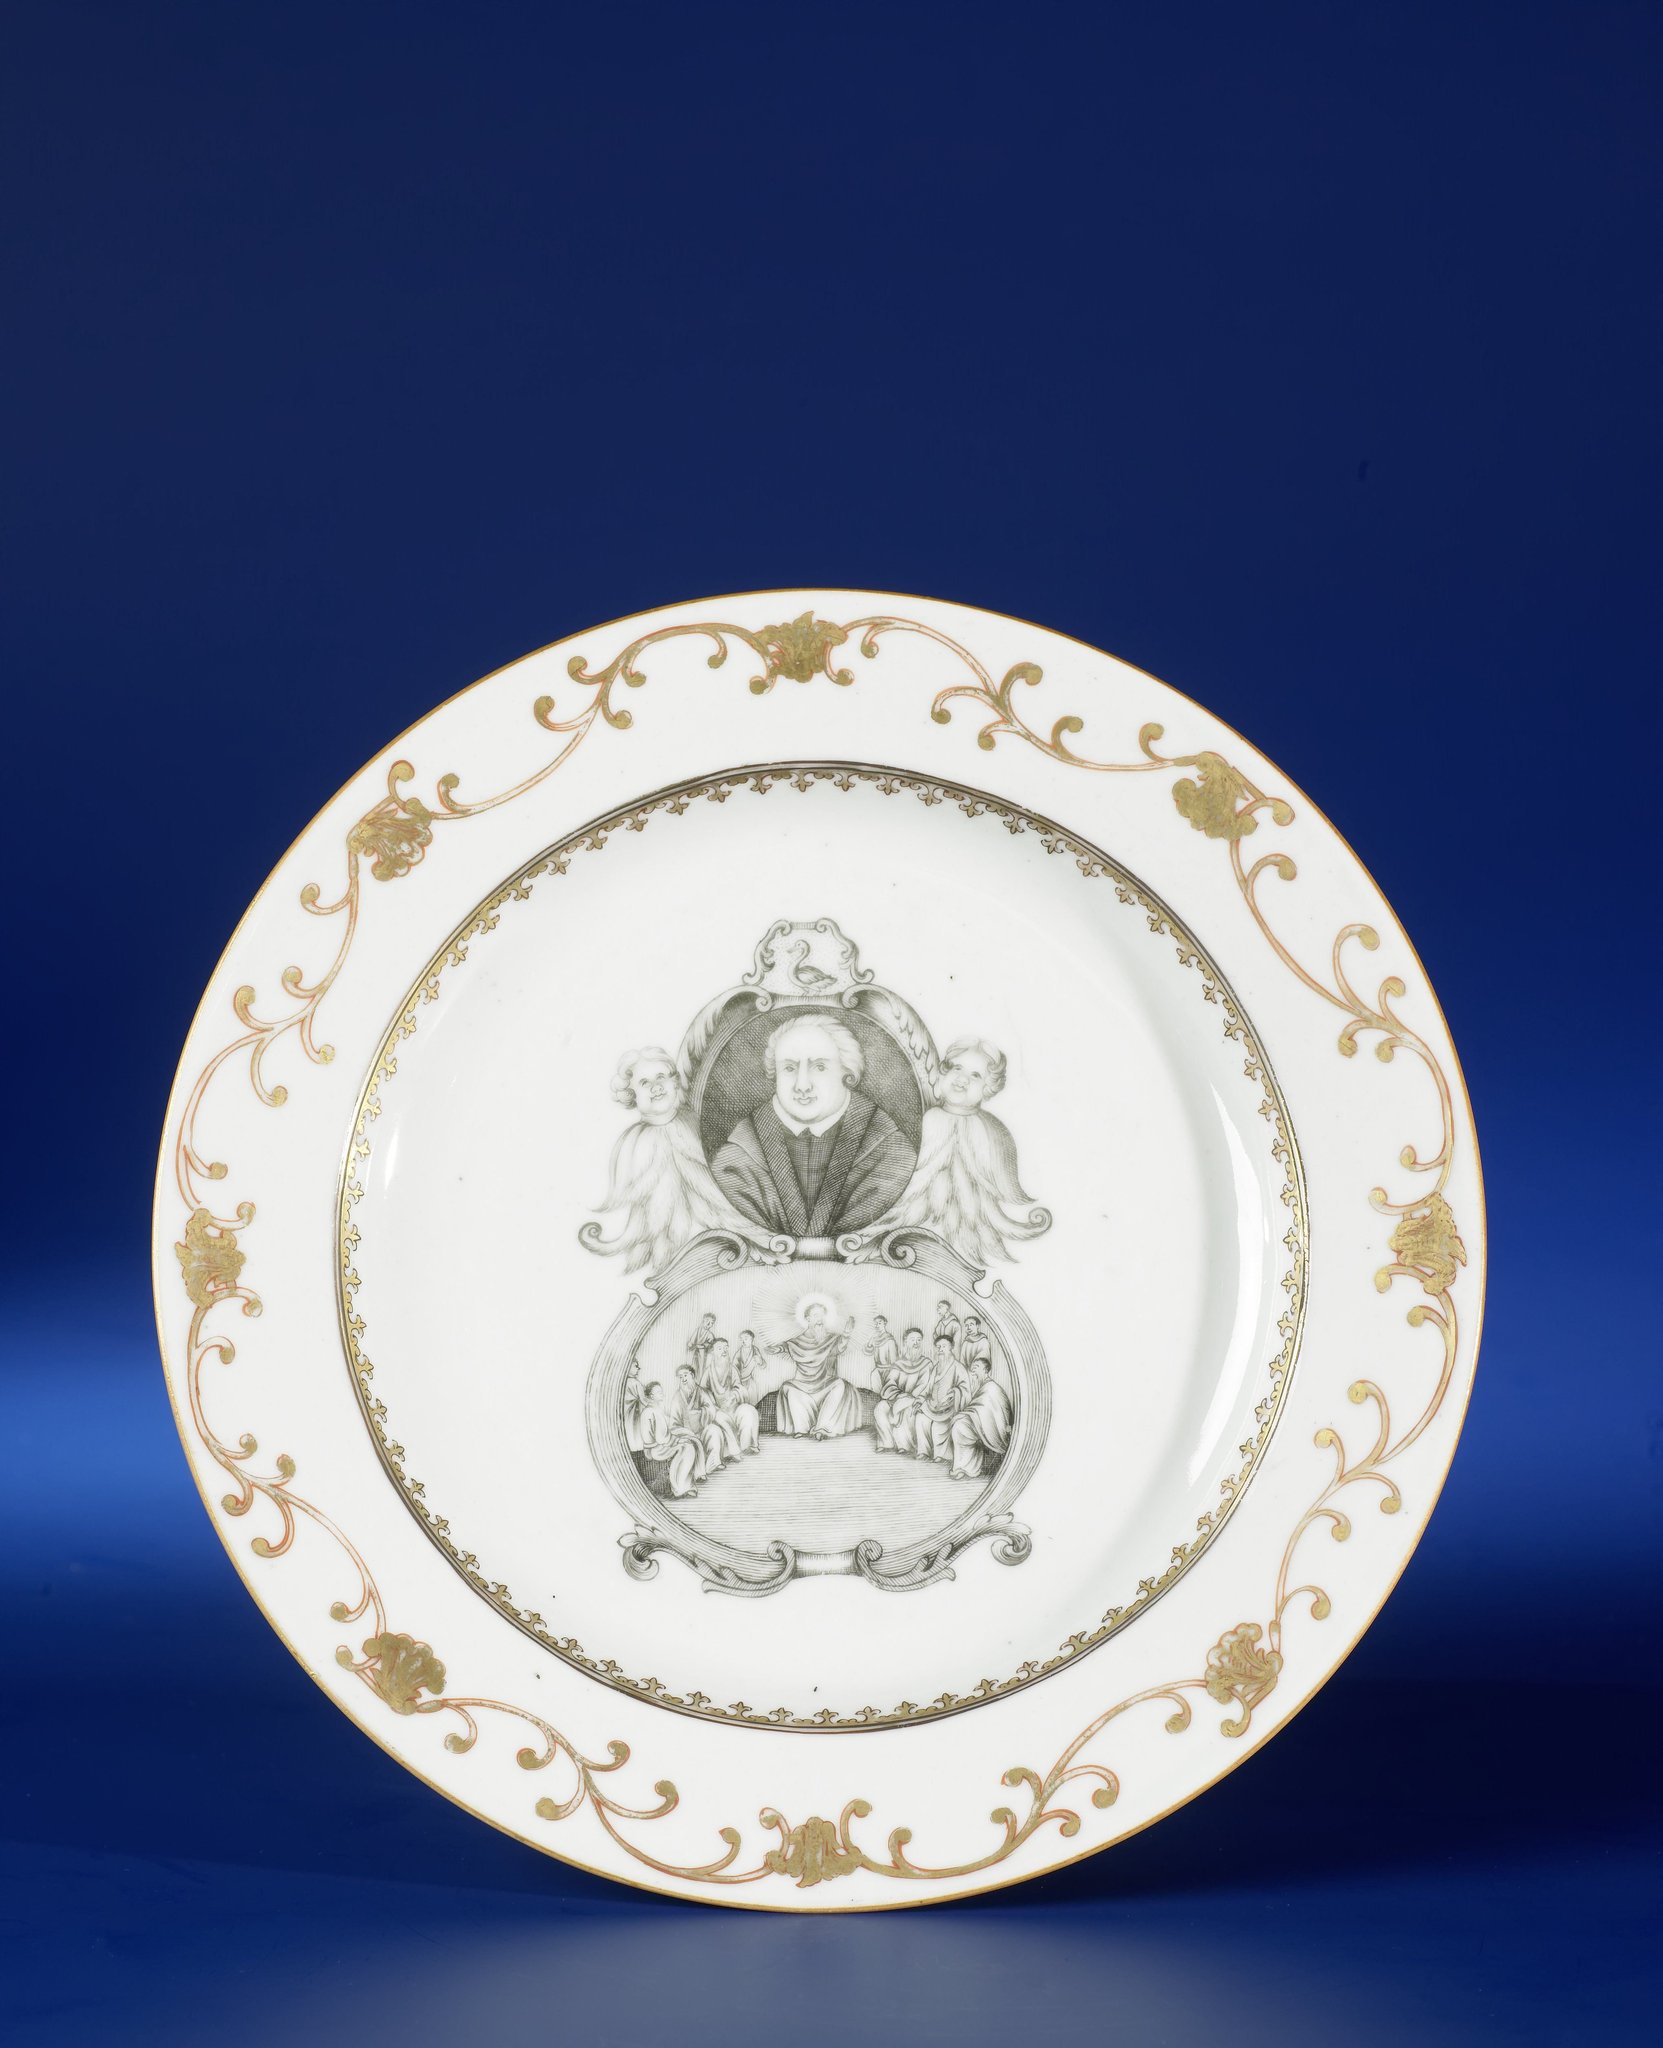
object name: plate dish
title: Plate with an image of Martin Luther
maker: Anonymous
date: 1740-1760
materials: glaze, gold, paint, porcelain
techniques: firing, gilding, turning, vitrification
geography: china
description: Bord op een voetring met een platte rand. Gedecoreerd in encre de Chine met een voorstelling van Martin Luther (1483-1546) binnen een cartouche. Daaronder binnen een cartouche een voorstelling van Christus met aan zijn linker en rechterzijde twaalf discipelen. Rondom een fleur de lys-rand; op de rand een decoratief patroon. Vanaf 1702 komt deze prent voor als titelpagina in de Lutherse Nederduytse Bijbel. De maker van de prent is onbekend.